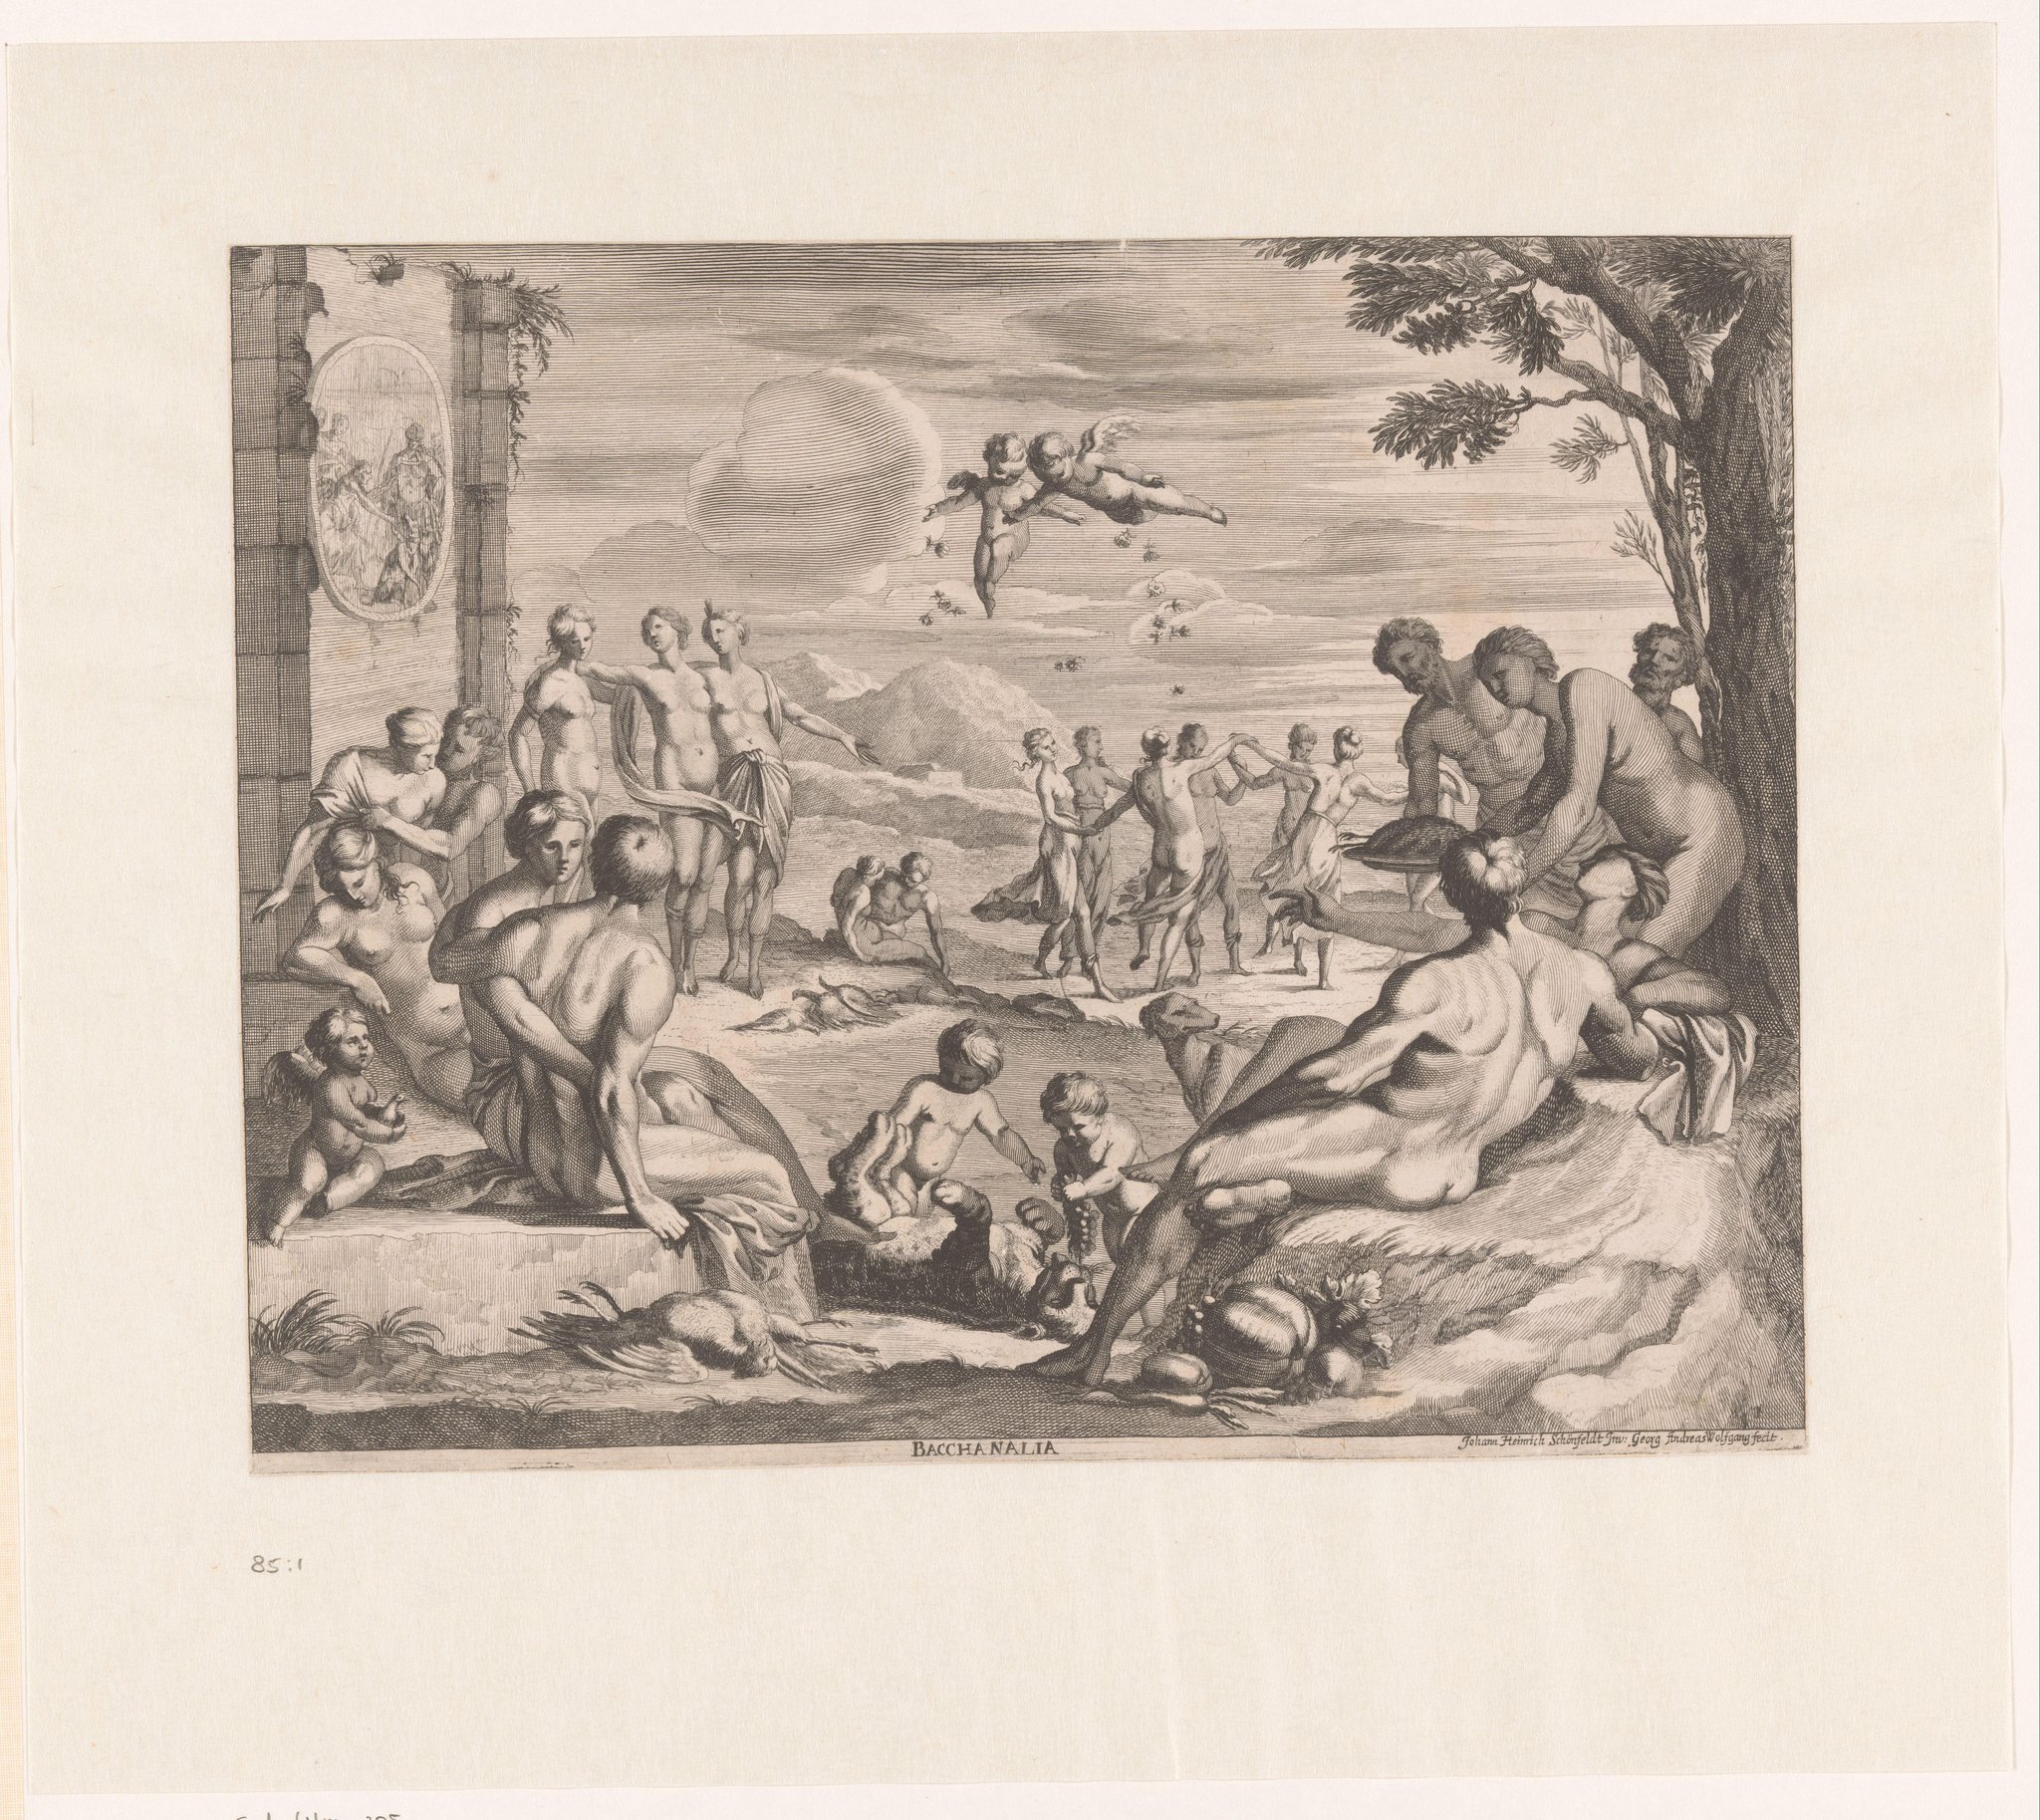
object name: print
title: Bacchanaal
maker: georg andreas wolfgang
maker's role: goldsmith, print maker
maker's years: 1631-1716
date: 1641-1716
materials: paper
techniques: etching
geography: germany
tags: thiasos, i.e. bacchus' revel-rout, bacchanal without bacchus, group dancing, cupids: 'amores', 'amoretti', 'putti'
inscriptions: collector's mark: Lugt 2228, collector's mark: Lugt 2760